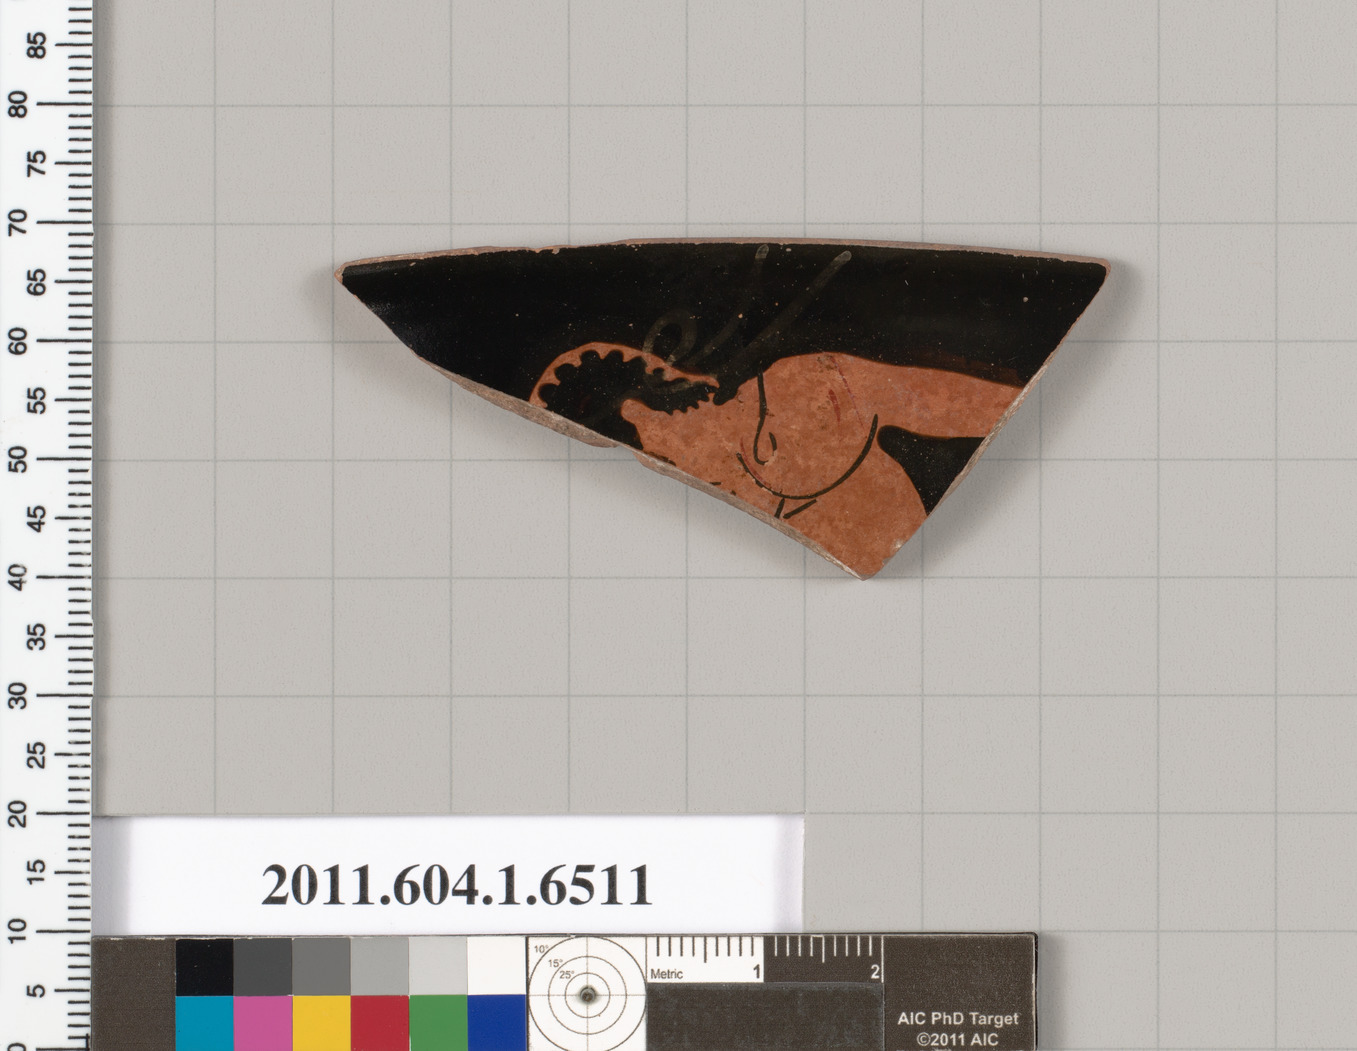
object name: kylix fragment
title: Terracotta rim fragment of a kylix (drinking cup)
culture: greek, attic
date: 490-480 BCE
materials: terracotta